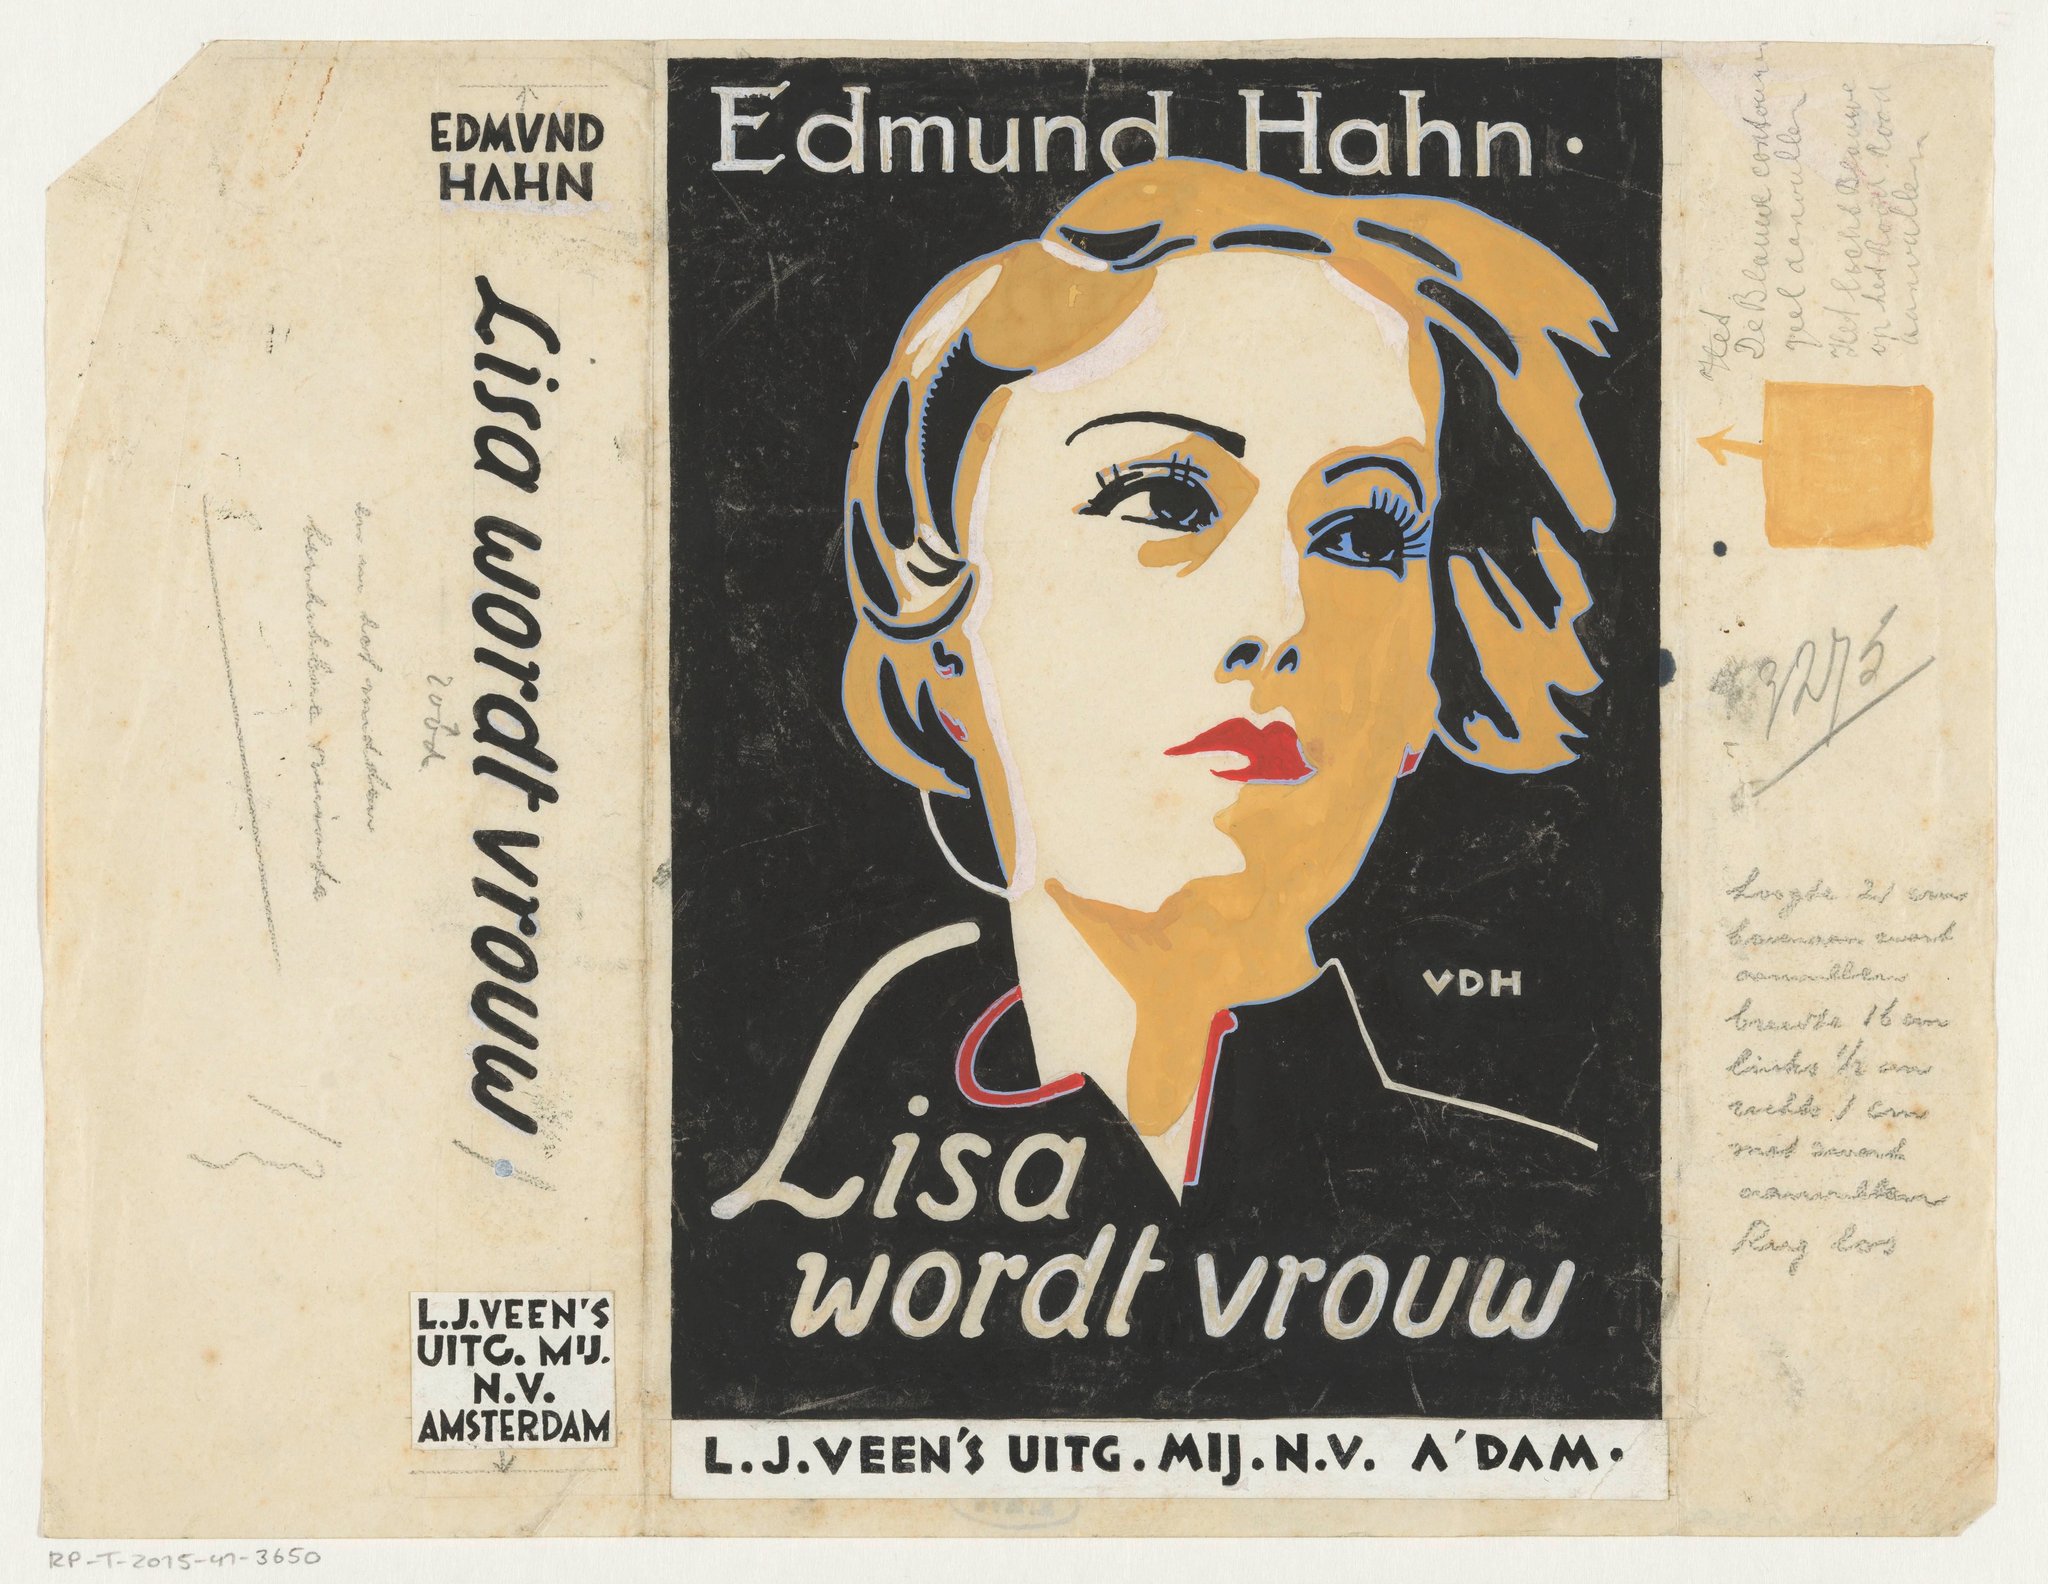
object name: study for binding design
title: Bandontwerp voor: Edmund Hahn, Lisa wordt vrouw (Lisa wird eine Frau), 1933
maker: Anonymous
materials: paint, paper, pencil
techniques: brush, printing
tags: face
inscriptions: collector's mark: Lugt 2228a, :, signature: ‘VDH’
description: Gezicht van een jonge vrouw met kort haar in een blouse met opstaande kraag.